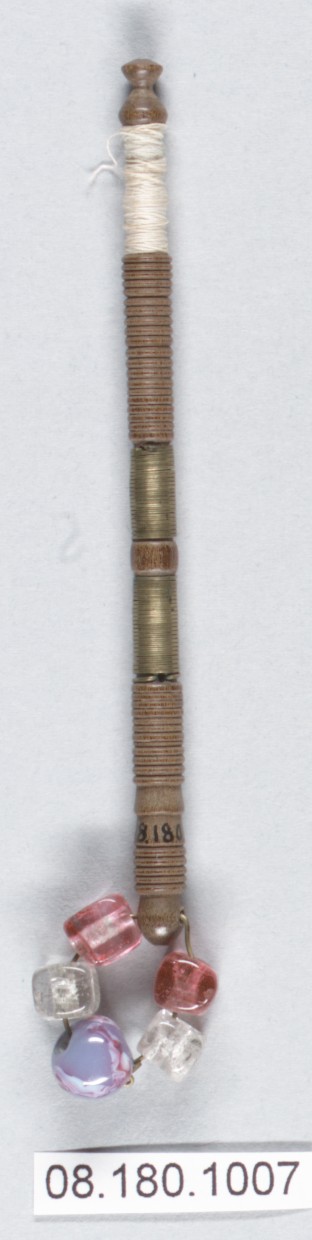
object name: bobbin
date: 1801-1900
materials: metal, wood